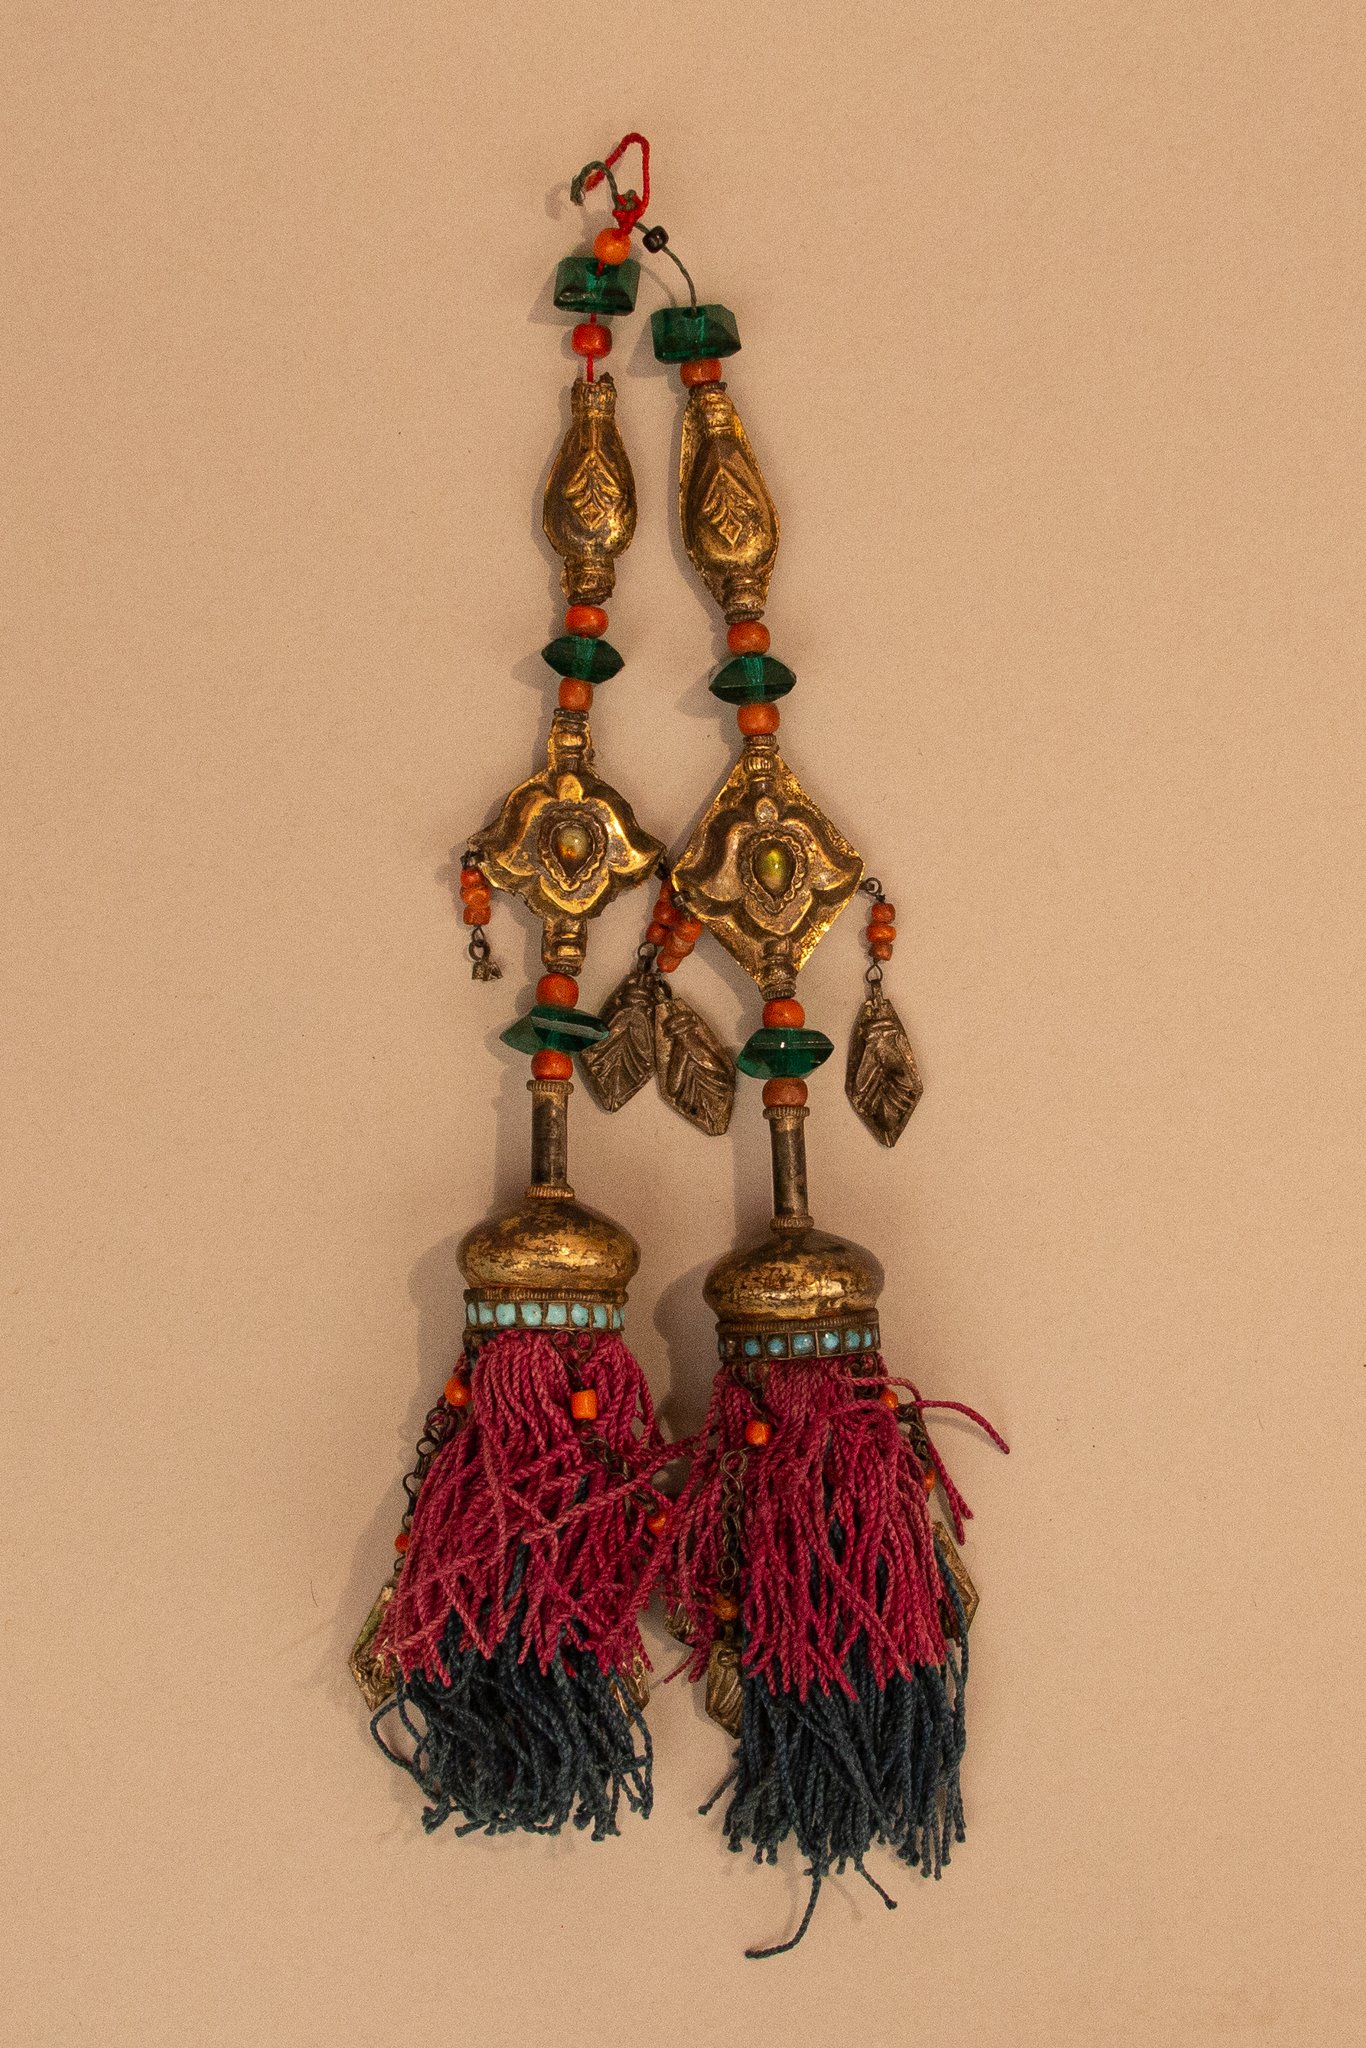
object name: ornament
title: Hair Ornament [or Plait Ornament]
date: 1801-1900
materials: coral, glass, gold, silk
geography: uzbekistan